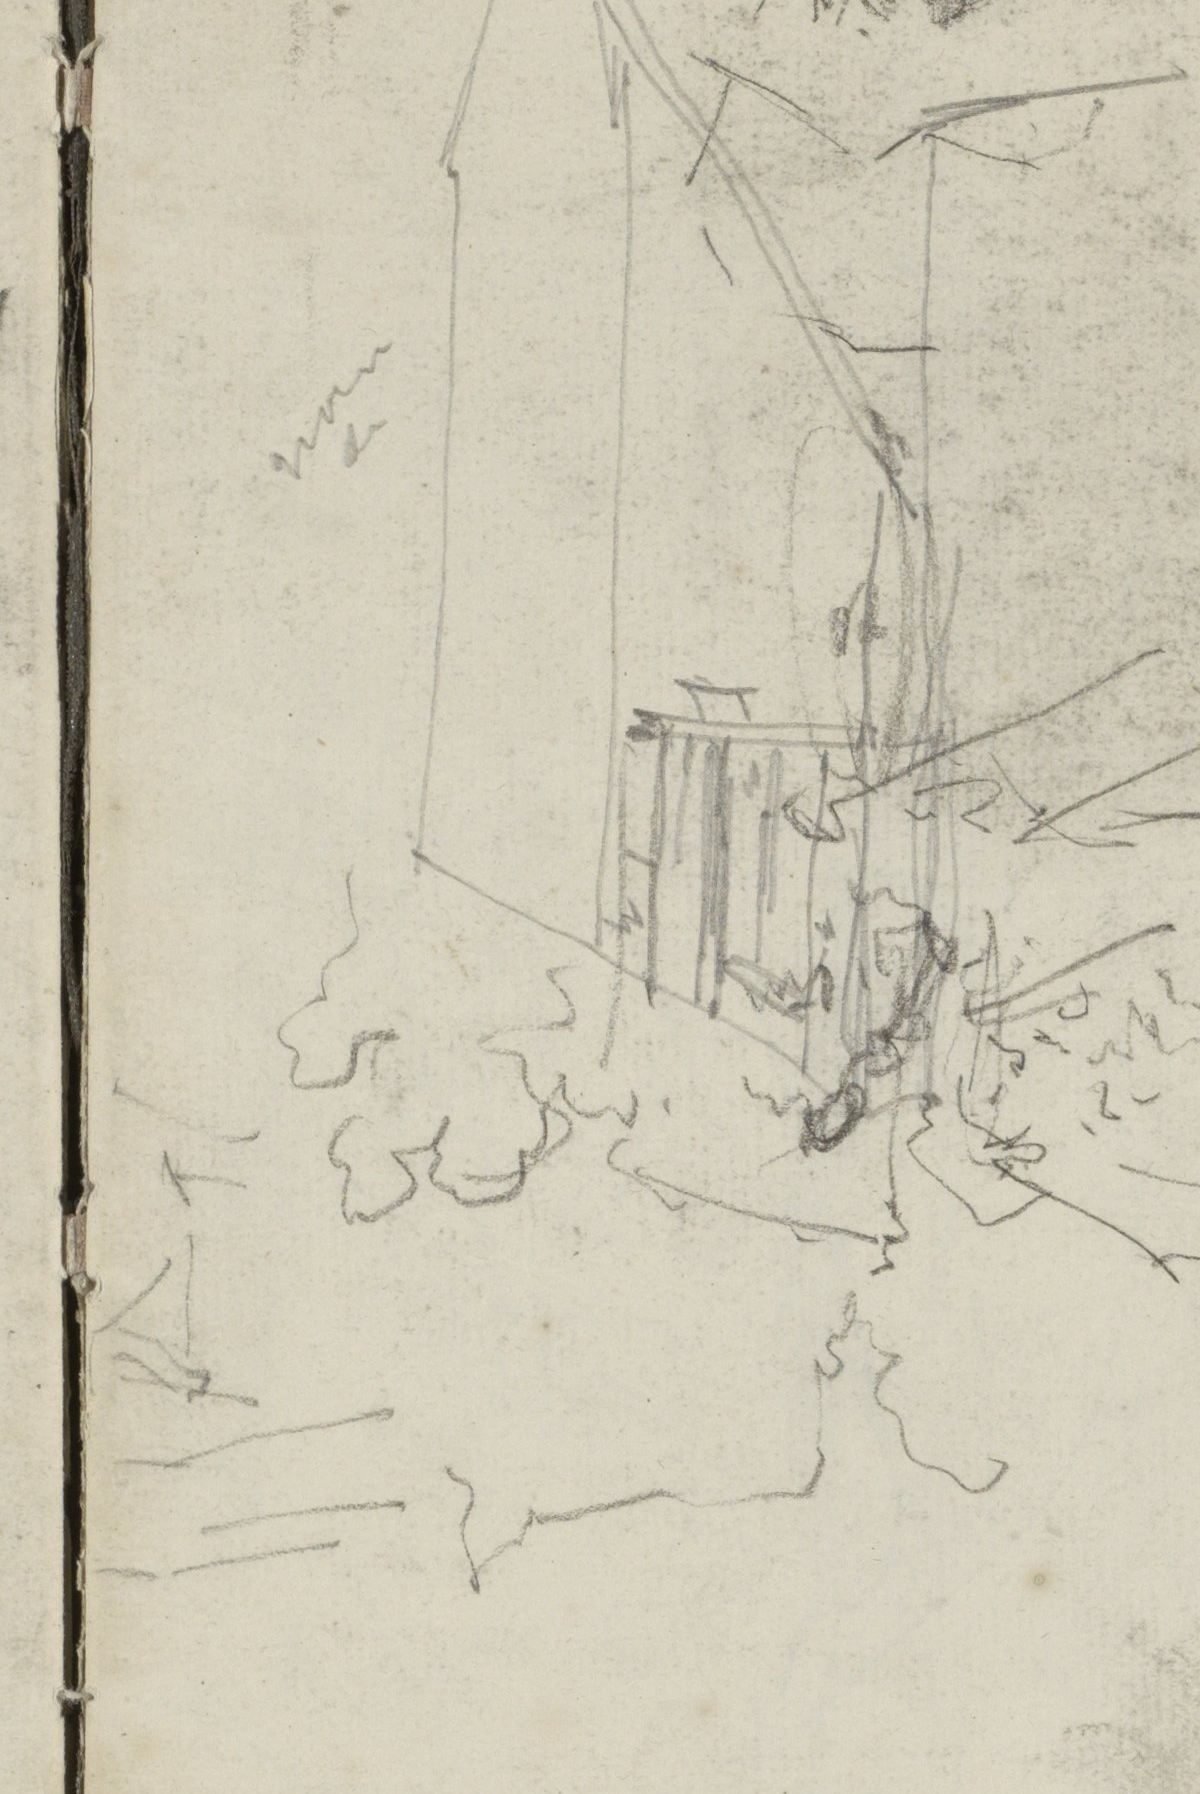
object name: sketchbook leaf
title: Gebouwen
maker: george hendrik breitner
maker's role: draughtsman, painter, print maker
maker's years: 1857-1923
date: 1880-1882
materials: chalk, paper, pencil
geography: the hague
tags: civic architecture; edifices; dwellings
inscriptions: kleurnotitie, handgeschreven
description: Pagina 26 uit een schetsboek met 23 bladen.